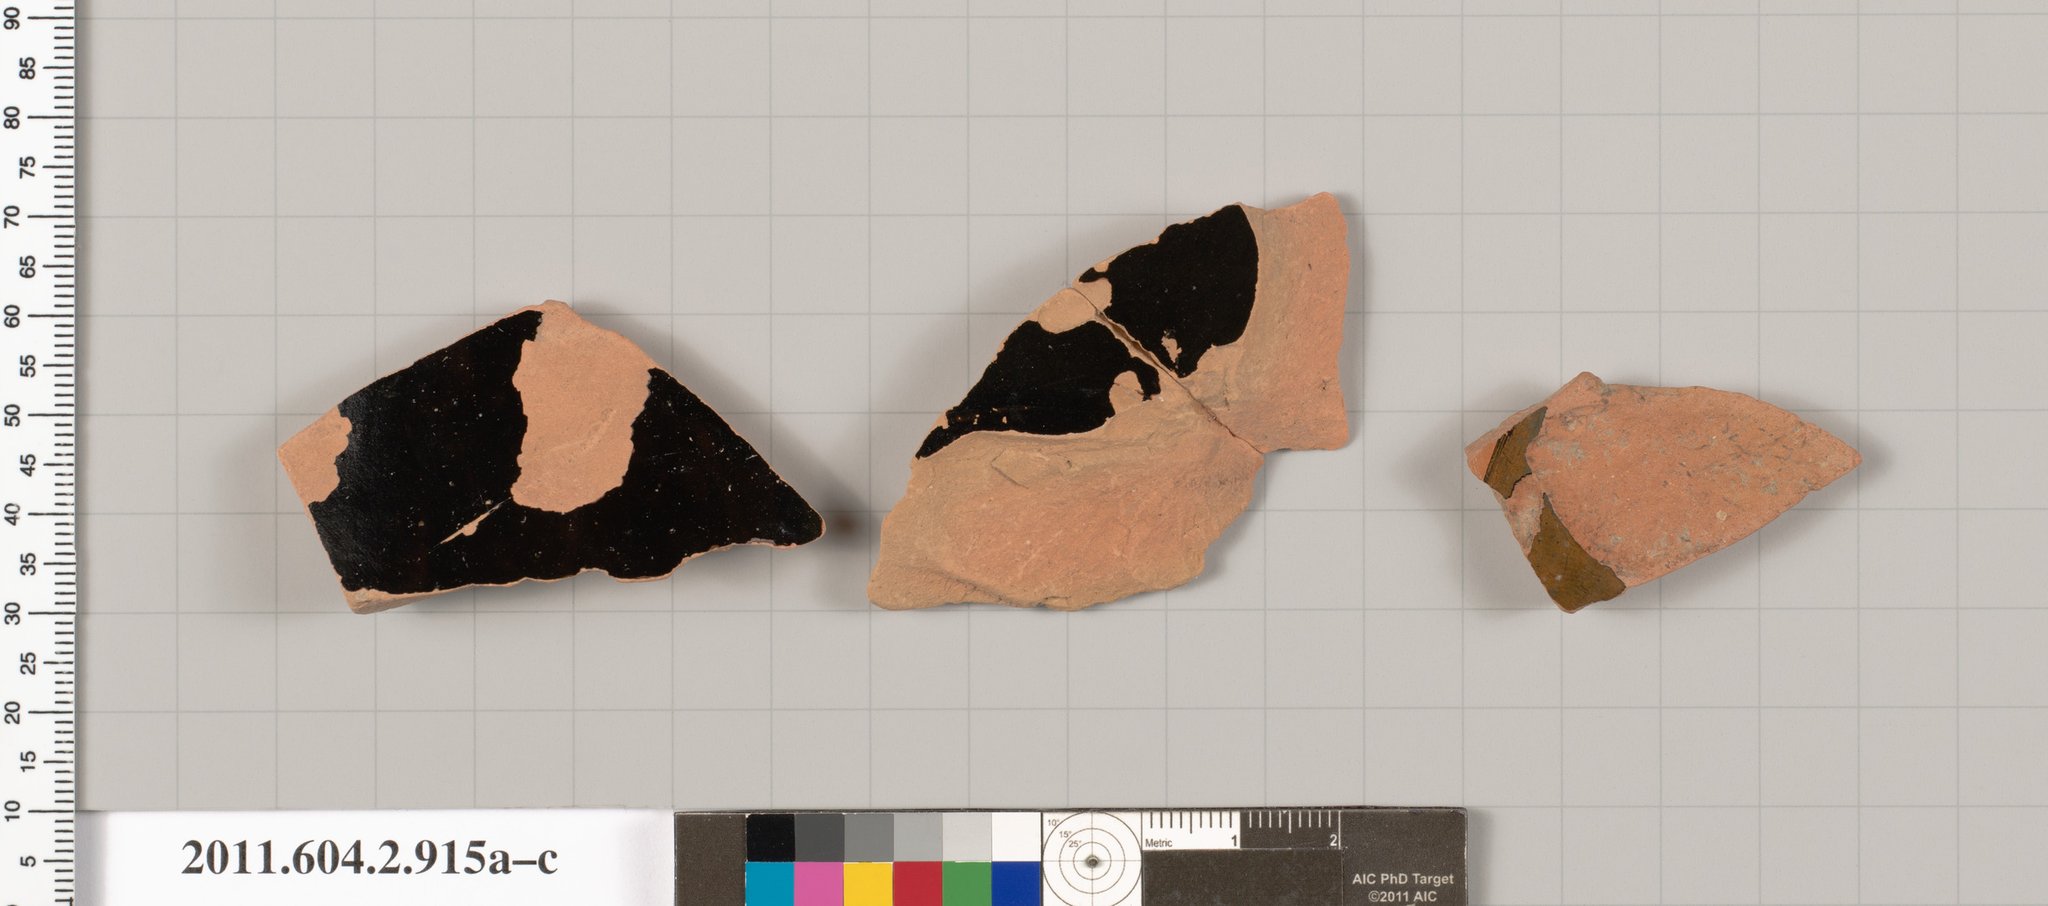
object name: bell krater fragment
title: Terracotta fragments of bell-kraters (bowls for mixing wine and water)?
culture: greek, attic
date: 450-401 BCE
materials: terracotta